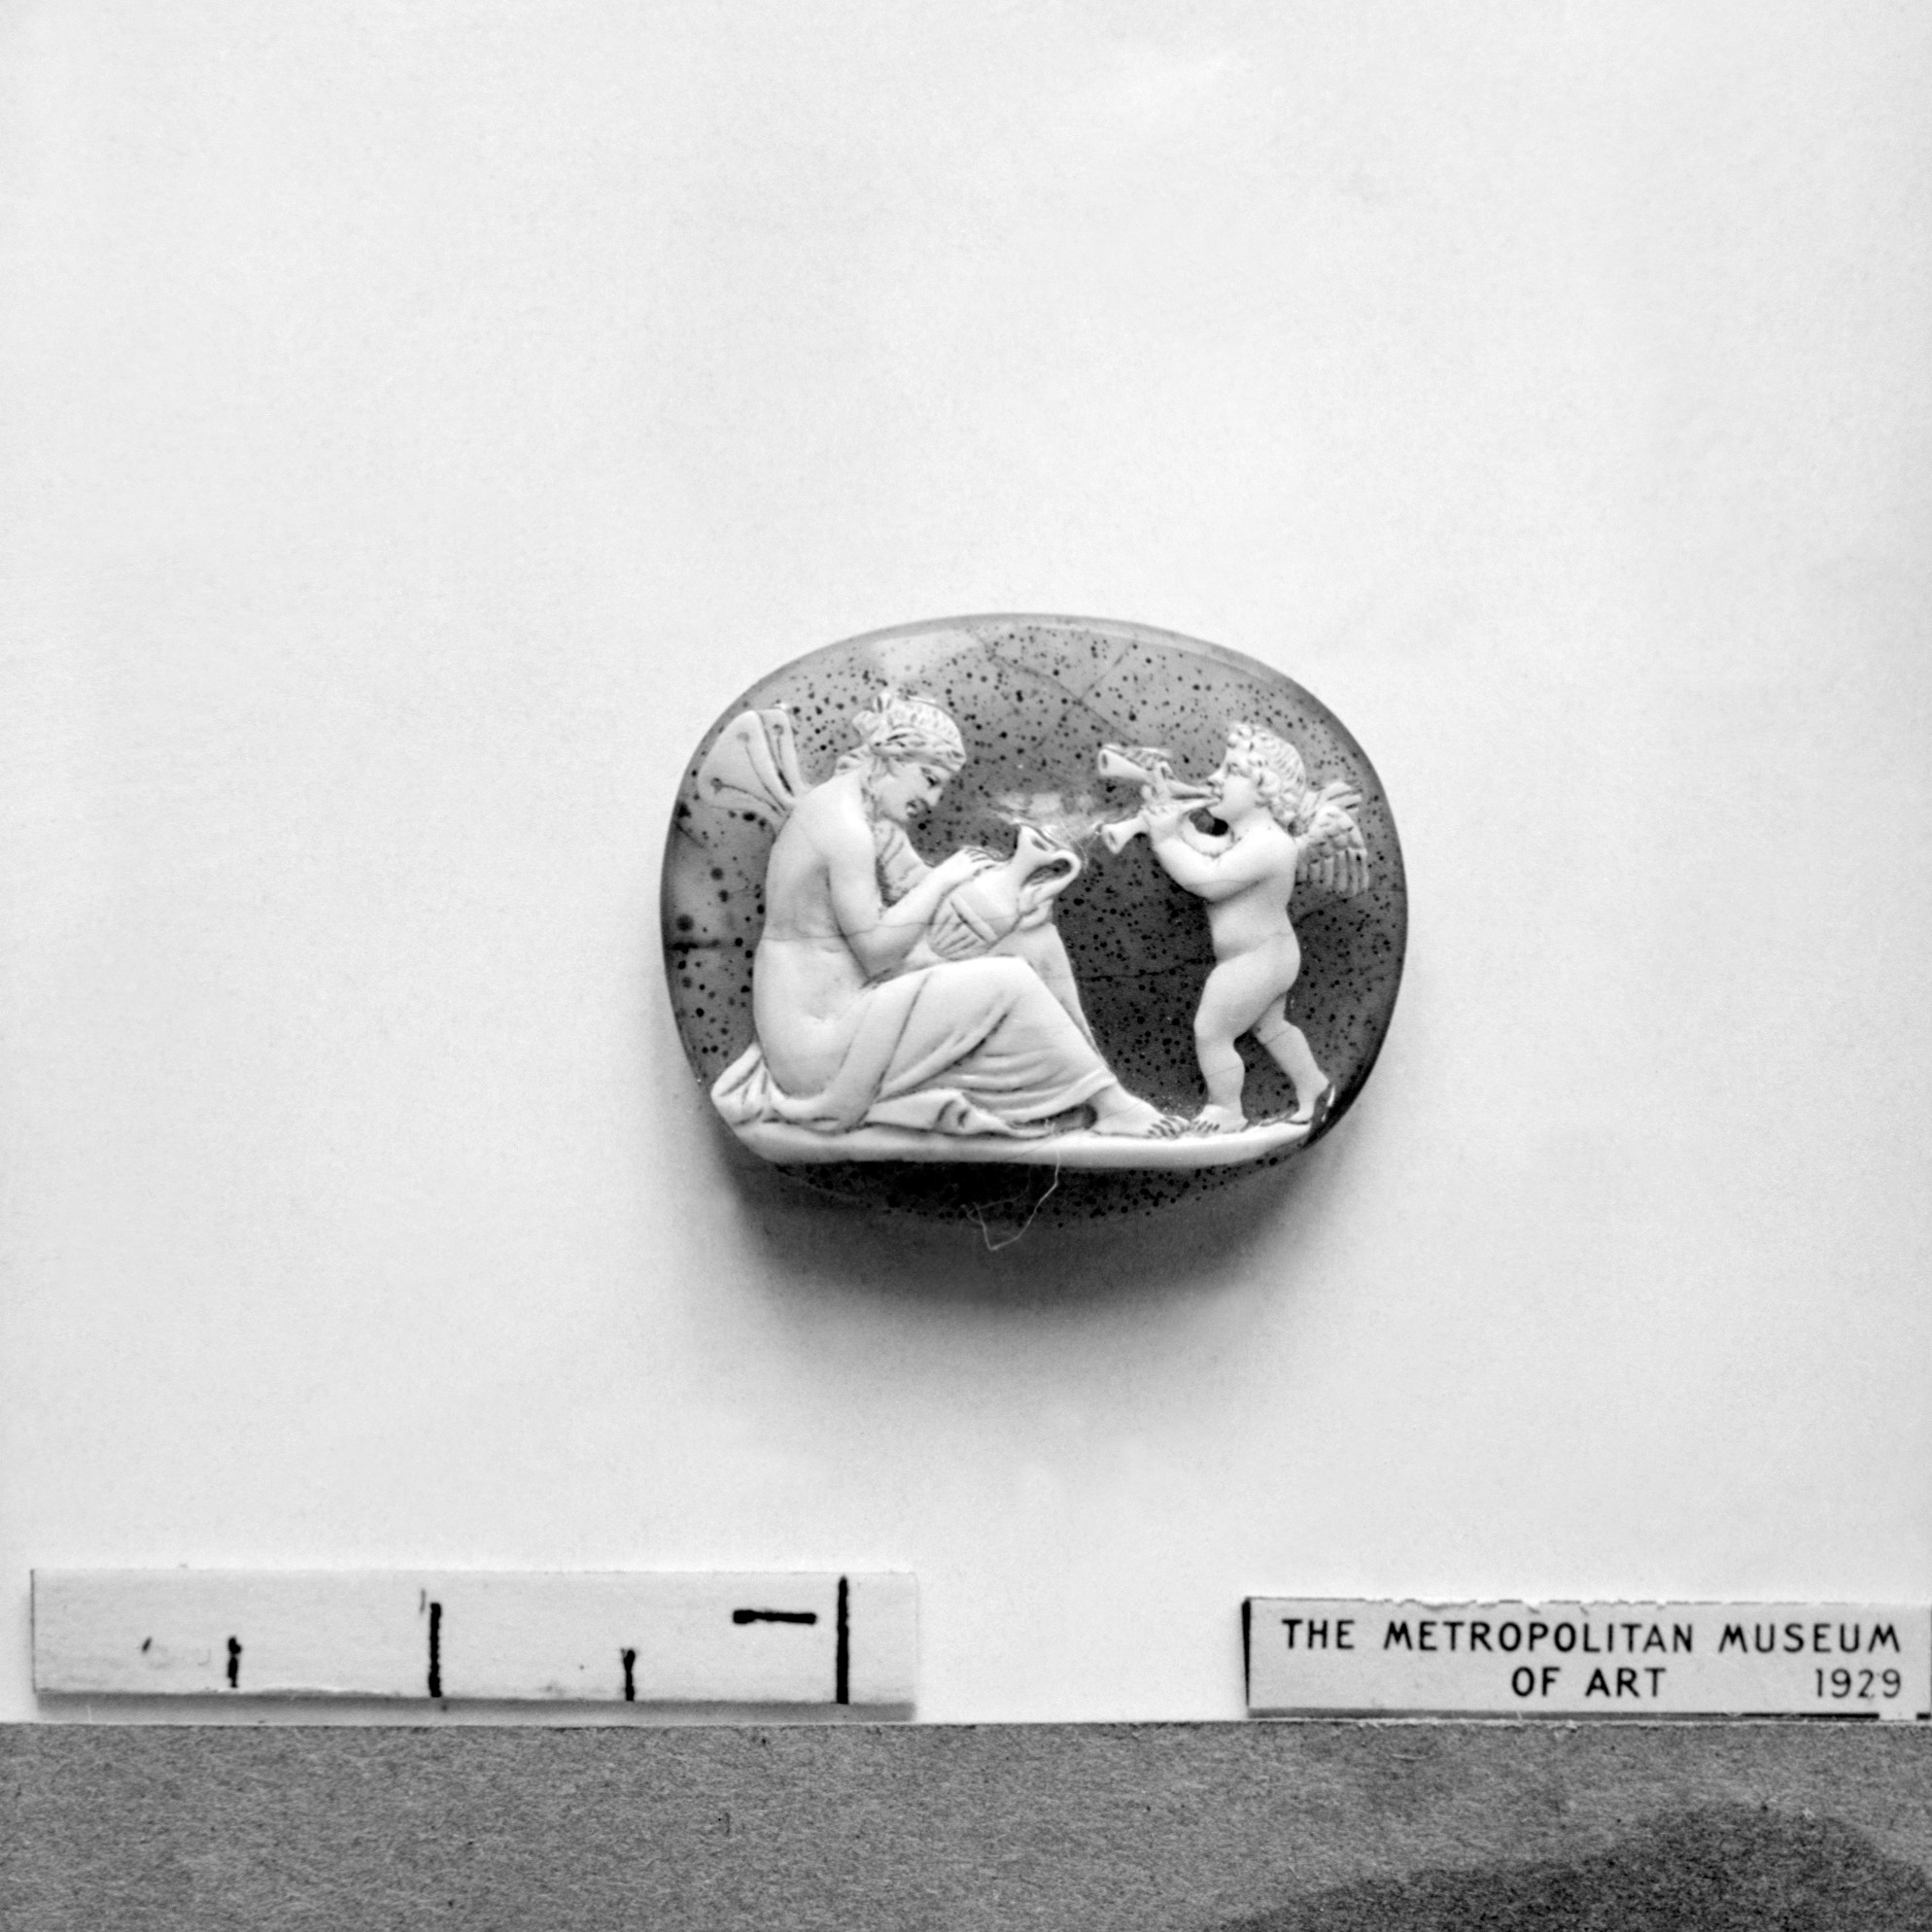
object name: cameo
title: Cupid and Psyche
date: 1767-1800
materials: gemstone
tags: musical instruments,cupid,psyche